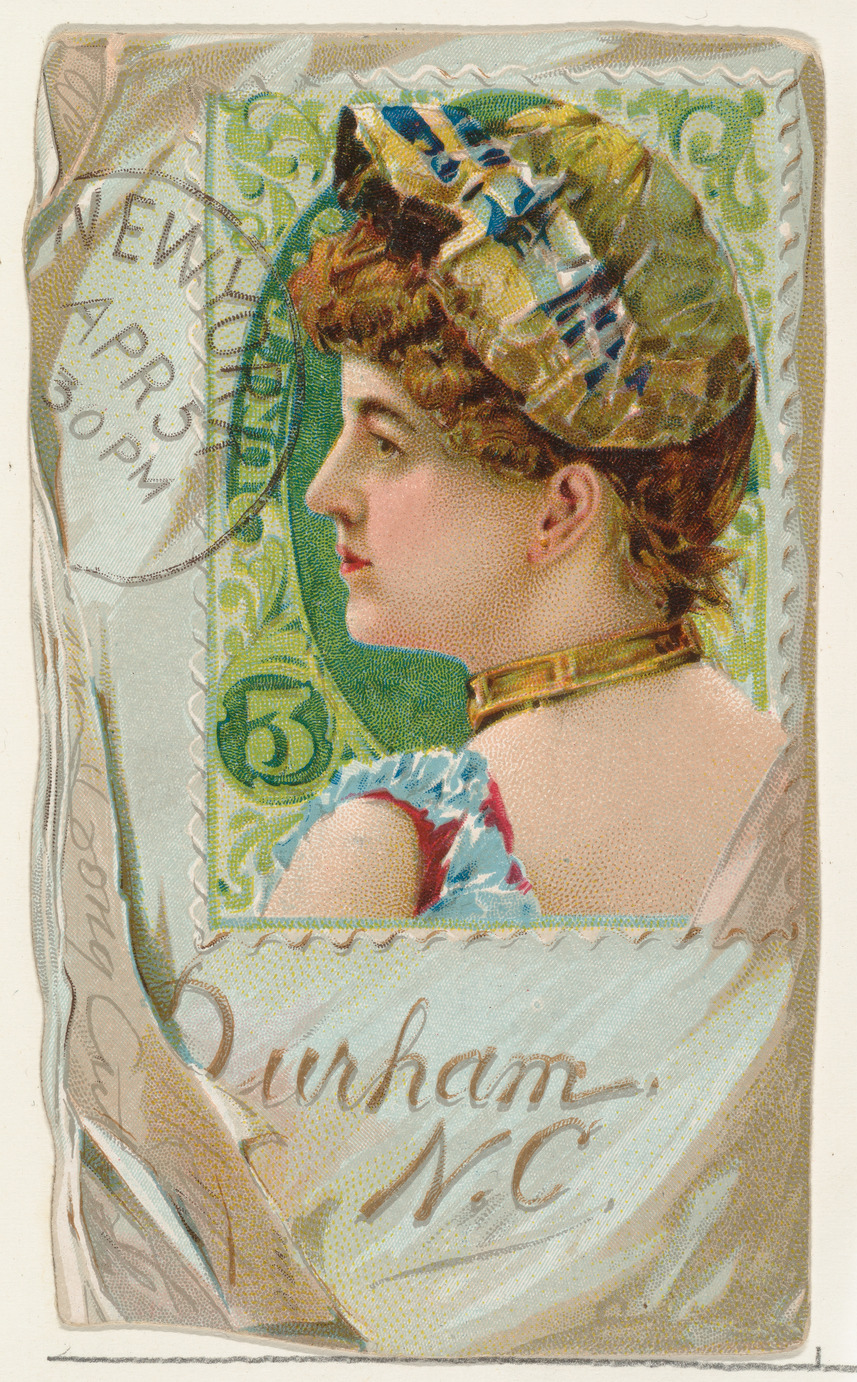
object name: print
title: Stamp on envelope, from the Novelties series (N122) issued by Gail & Ax Tobacco to promote Navy Long Cut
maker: gail & ax tobacco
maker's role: publisher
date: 1889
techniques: color lithograph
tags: profiles,women